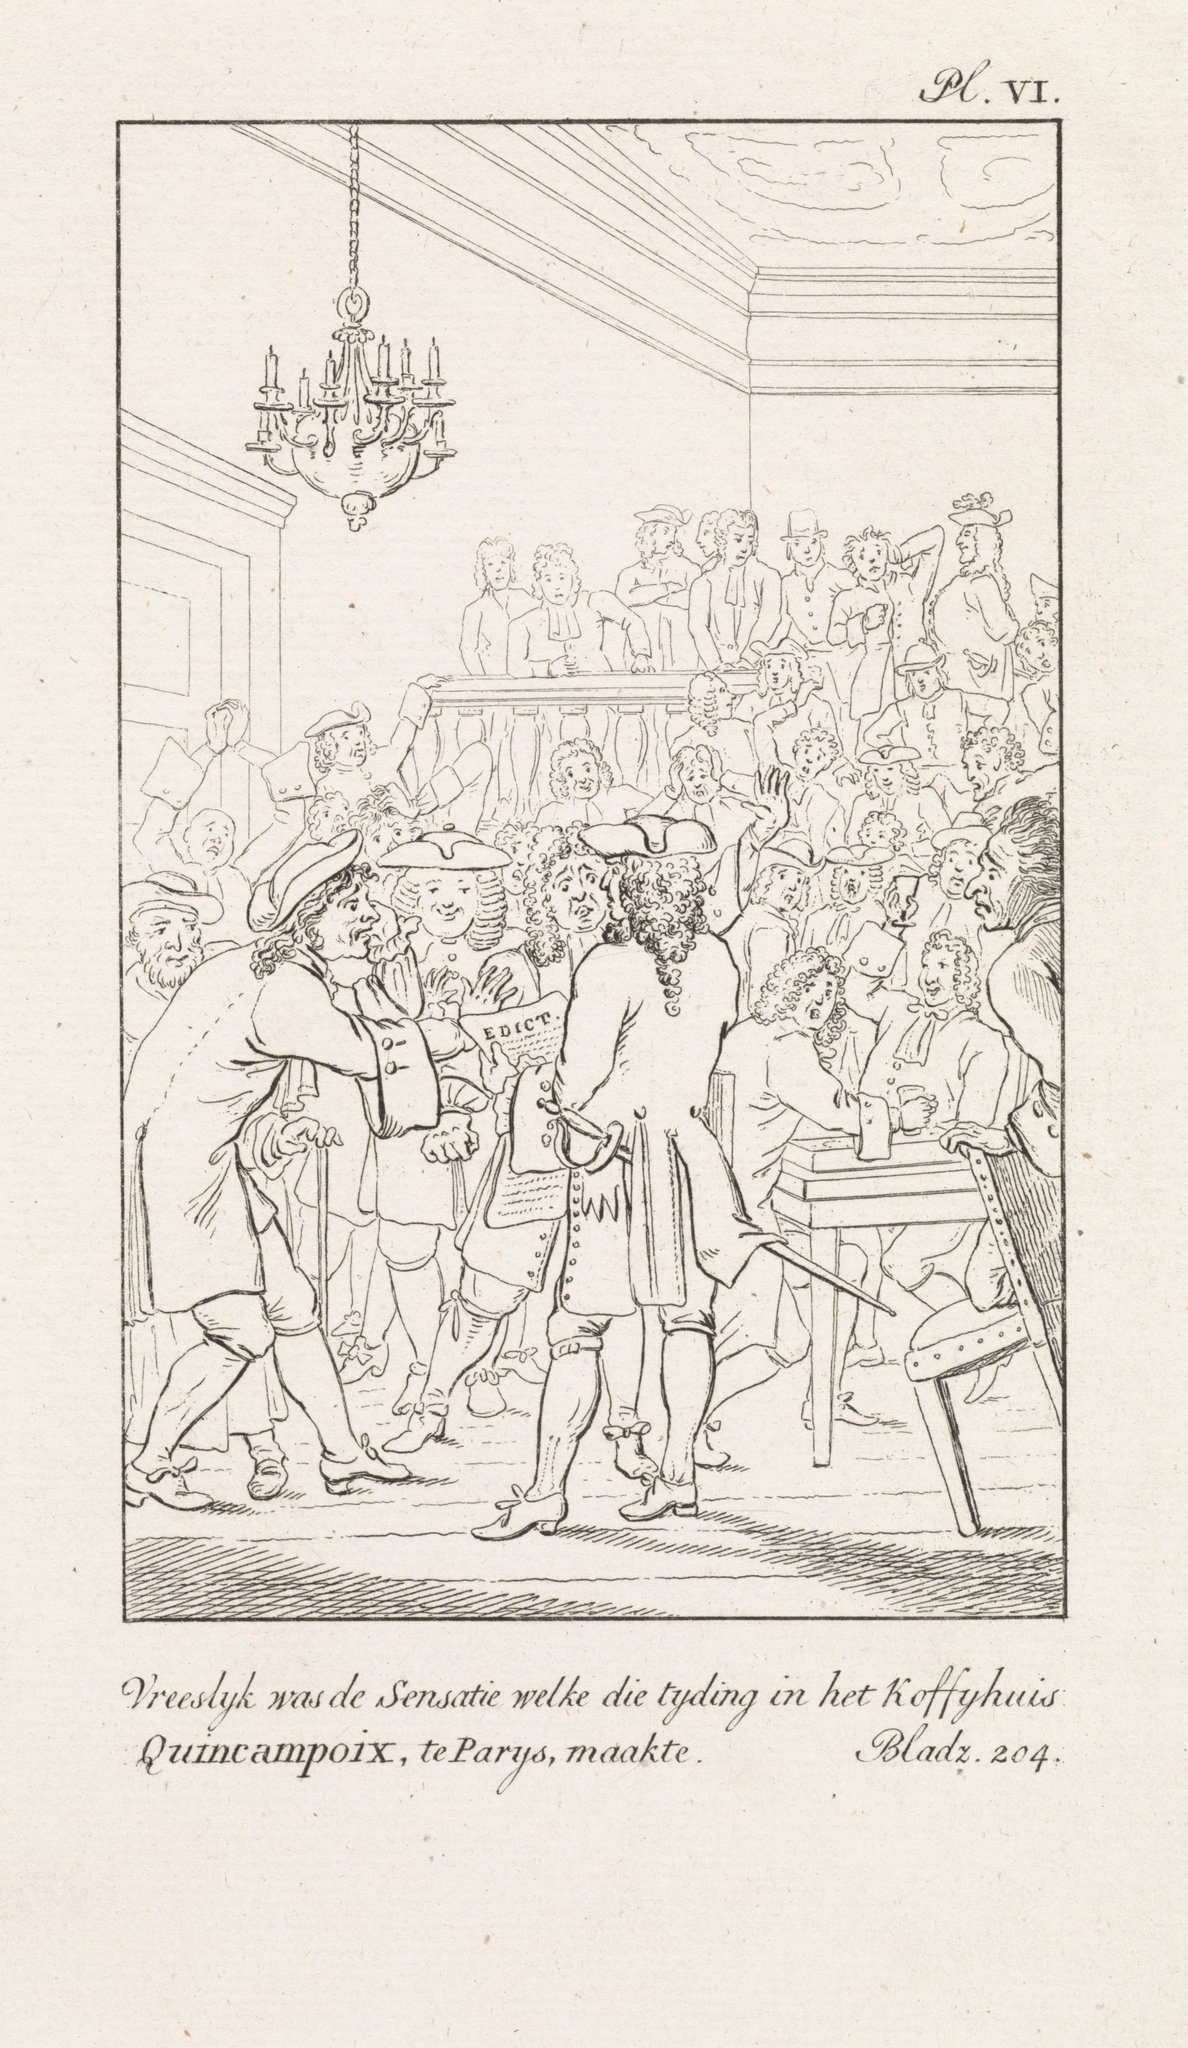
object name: print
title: Vreselijk was de sensatie welke die tijding in het koffijhuis Quincampoix, te Parijs, maakte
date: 1802-1809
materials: paper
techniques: etching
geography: haarlem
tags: inn, coffee-house, public house, etc., political caricatures and satires, paris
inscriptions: collector's mark: Lugt 2228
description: Prent als boekillustratie gebruikt in: Fokke Simonsz., Arend. Het hoekjen van den haard of Historie van Frankrijk. Deel IV-VII uit: Boertige Reis door Europa. 7 dln. Haarlem: François Bohn, 1802-1809.